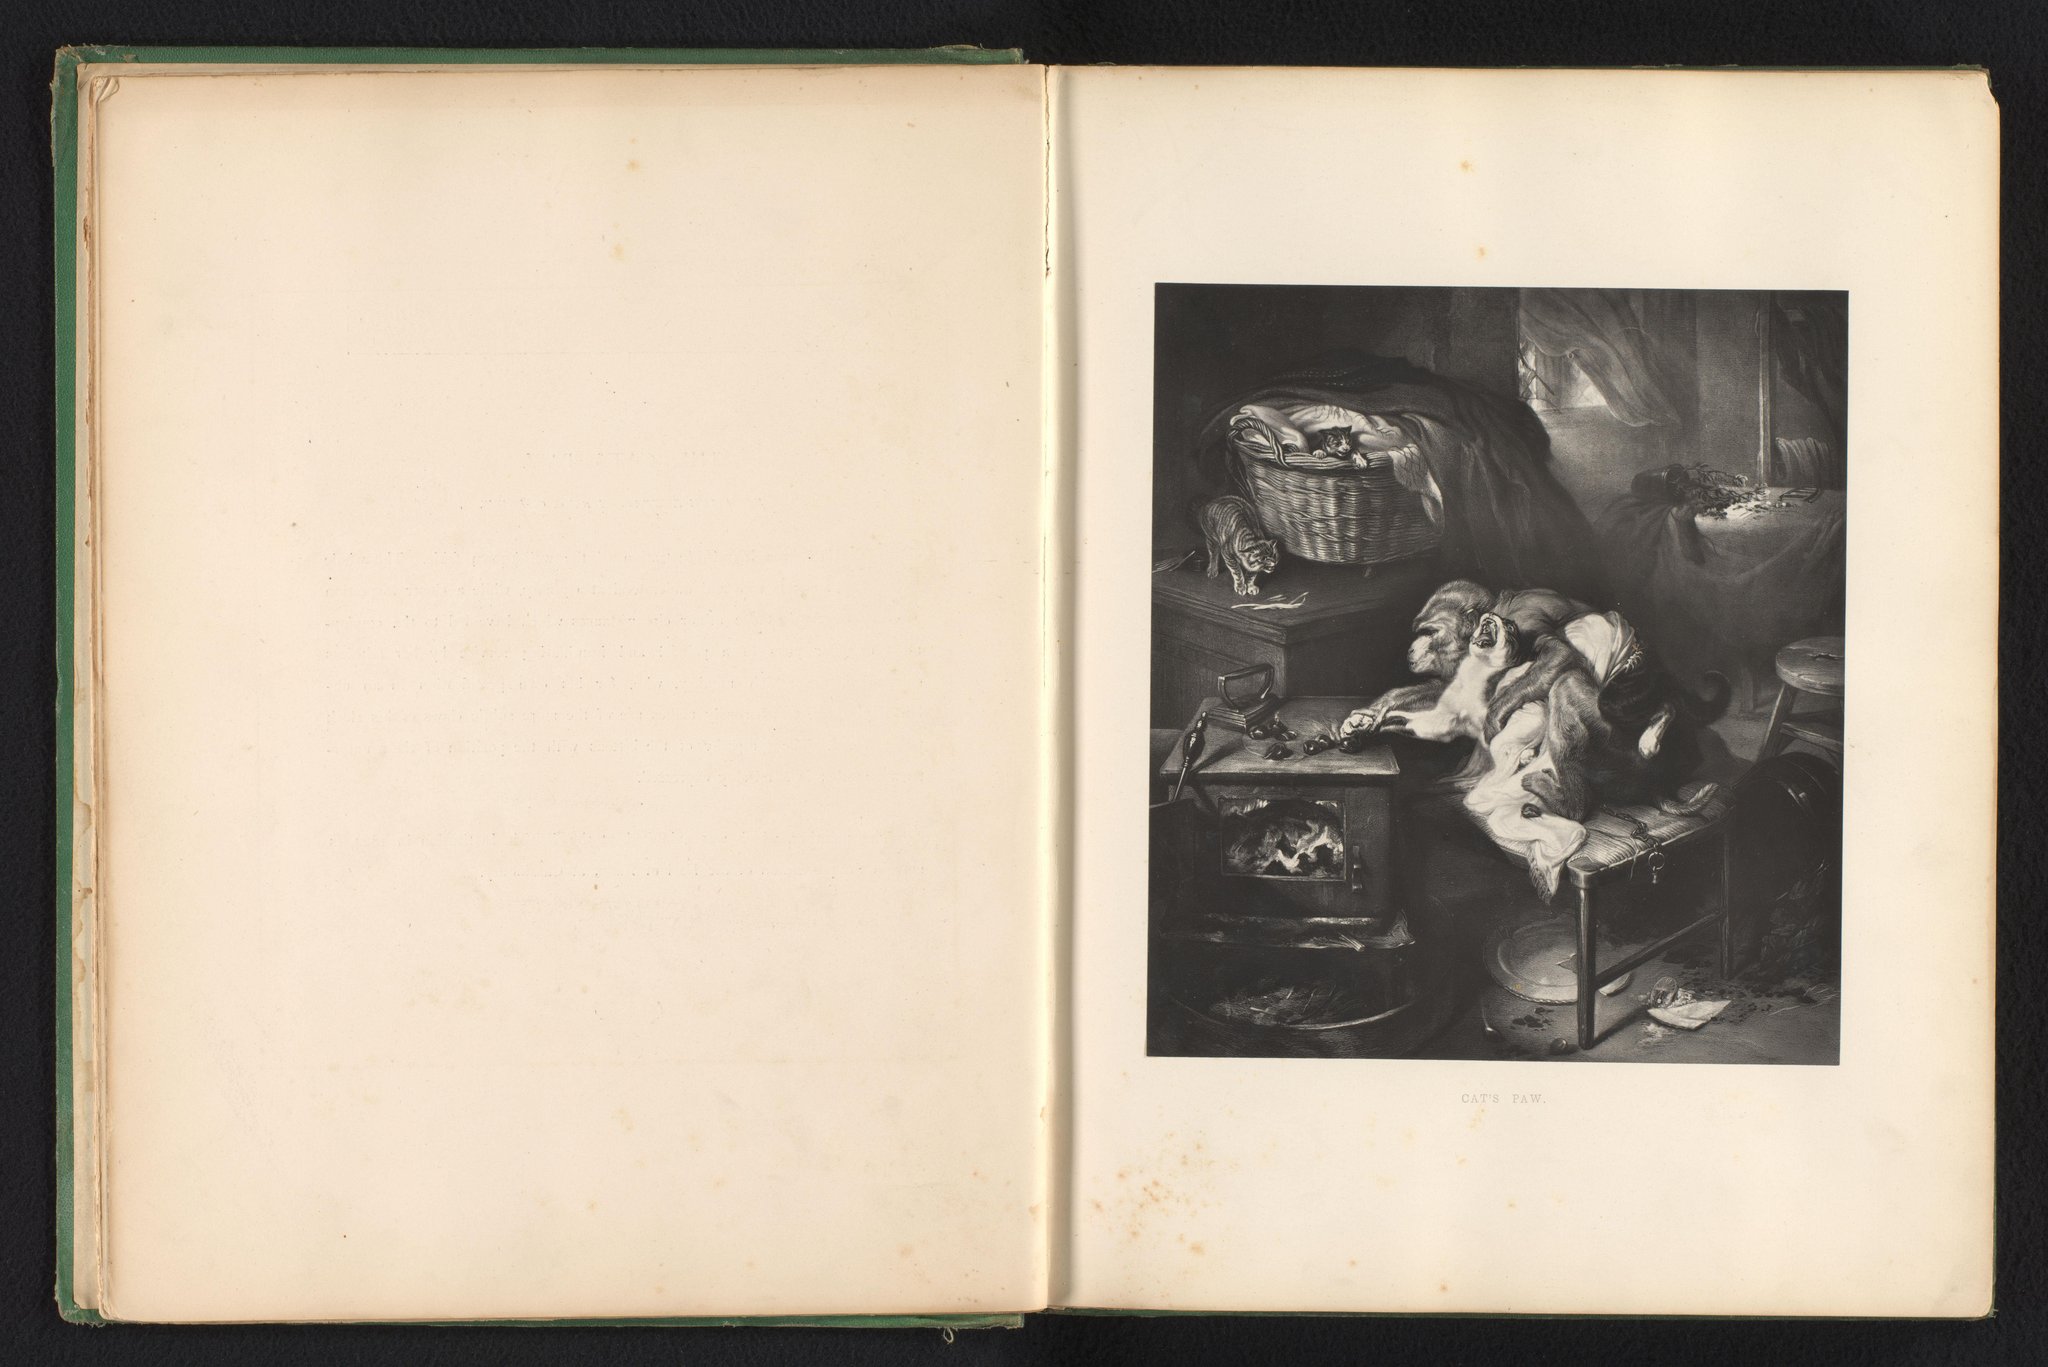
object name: photomechanical print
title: The cat's paw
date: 1878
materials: paper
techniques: woodburytype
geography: london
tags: cat, monkeys, apes, cruelty, ferocity; 'crudeltà', 'ferocità' (ripa)